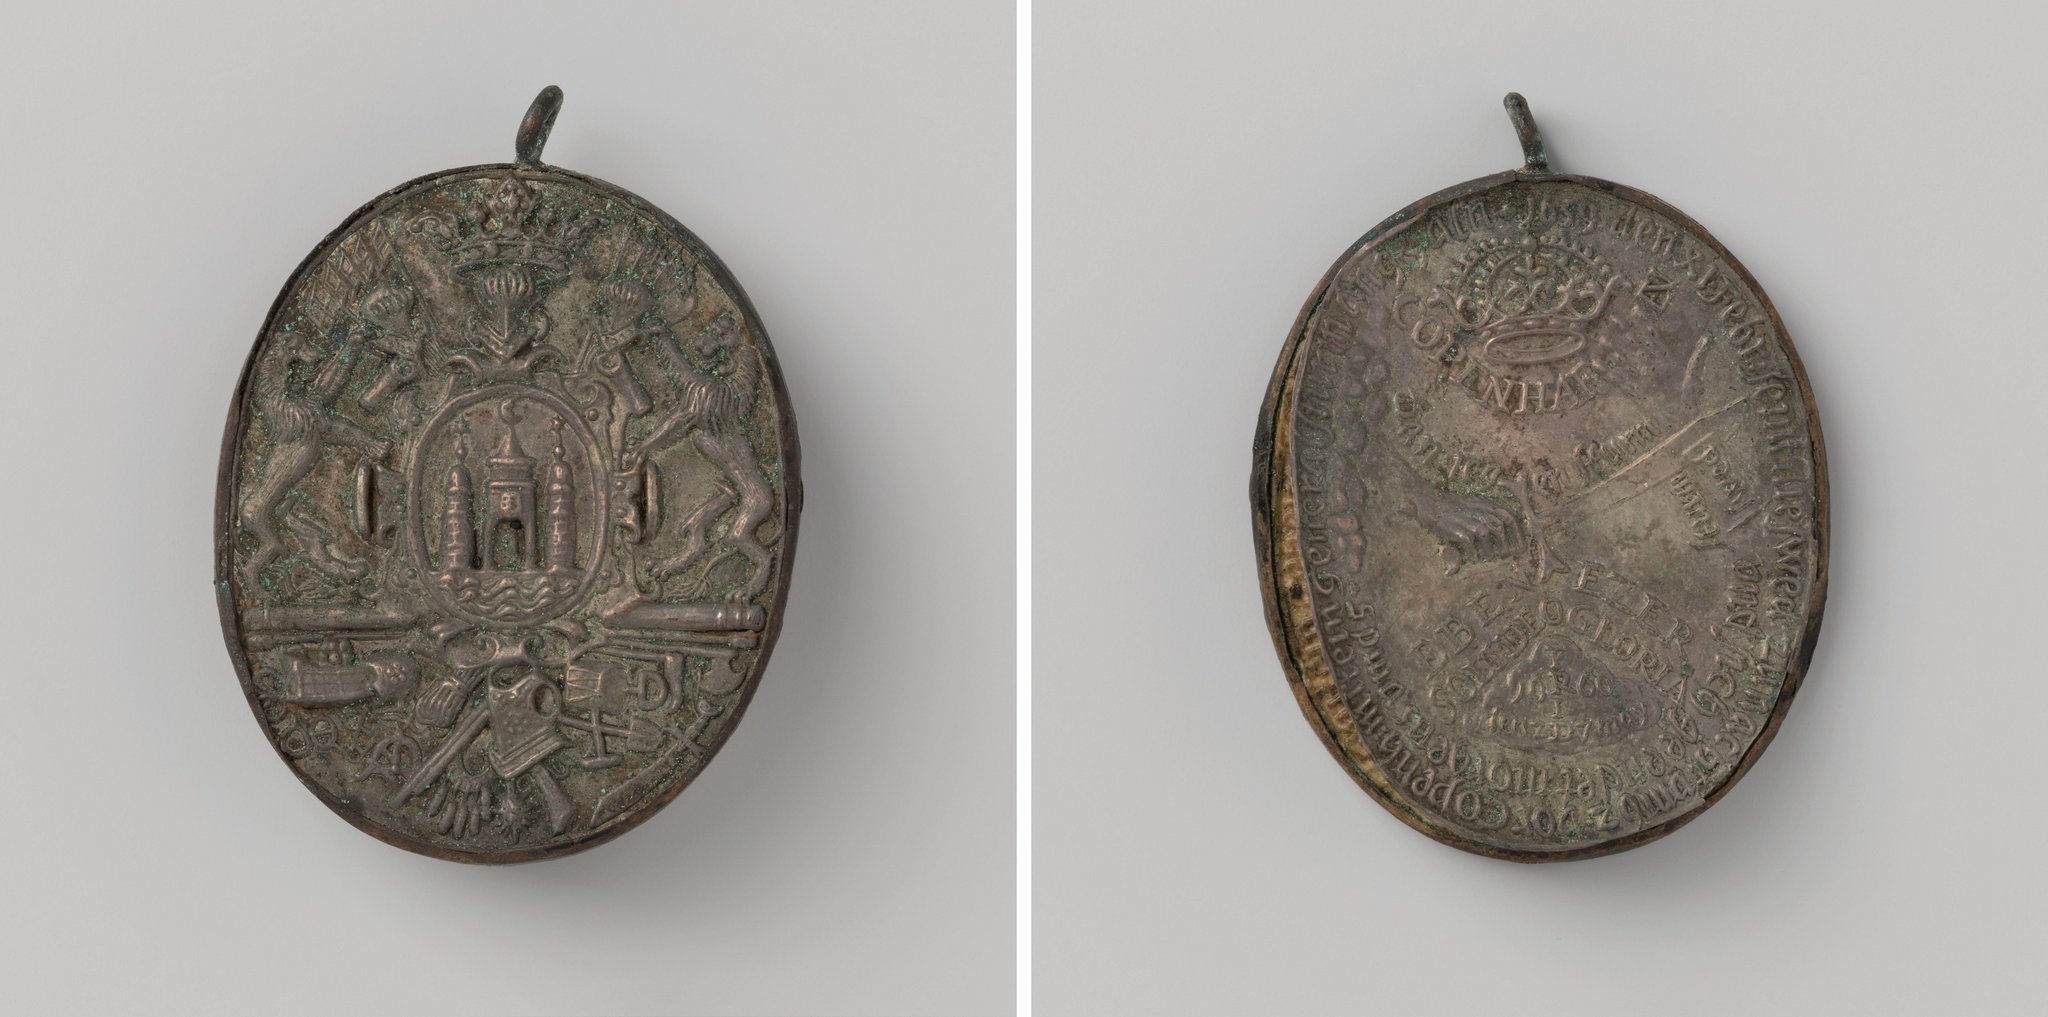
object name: honorary medal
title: Aanslag van de Zweden op Kopenhagen en vrede van Kopenhagen tussen Denemarken en Zweden, ter ere van Frederik III, koning van Denemarken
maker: Anonymous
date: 1660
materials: cardboard, silver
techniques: striking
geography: denmark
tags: copenhagen (city)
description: Zilveren ovale penning met draagoog. Voorzijde: wapenschild van Kopenhagen onder drie helmen, geflankeerd door twee leeuwen, boven wapentuig. Keerzijde: hand uit wolken met opschrift DAN hakt hand met opschrift SWED in tweeen, die naar kroon grijpt boven opschrift, binnen omschrift.